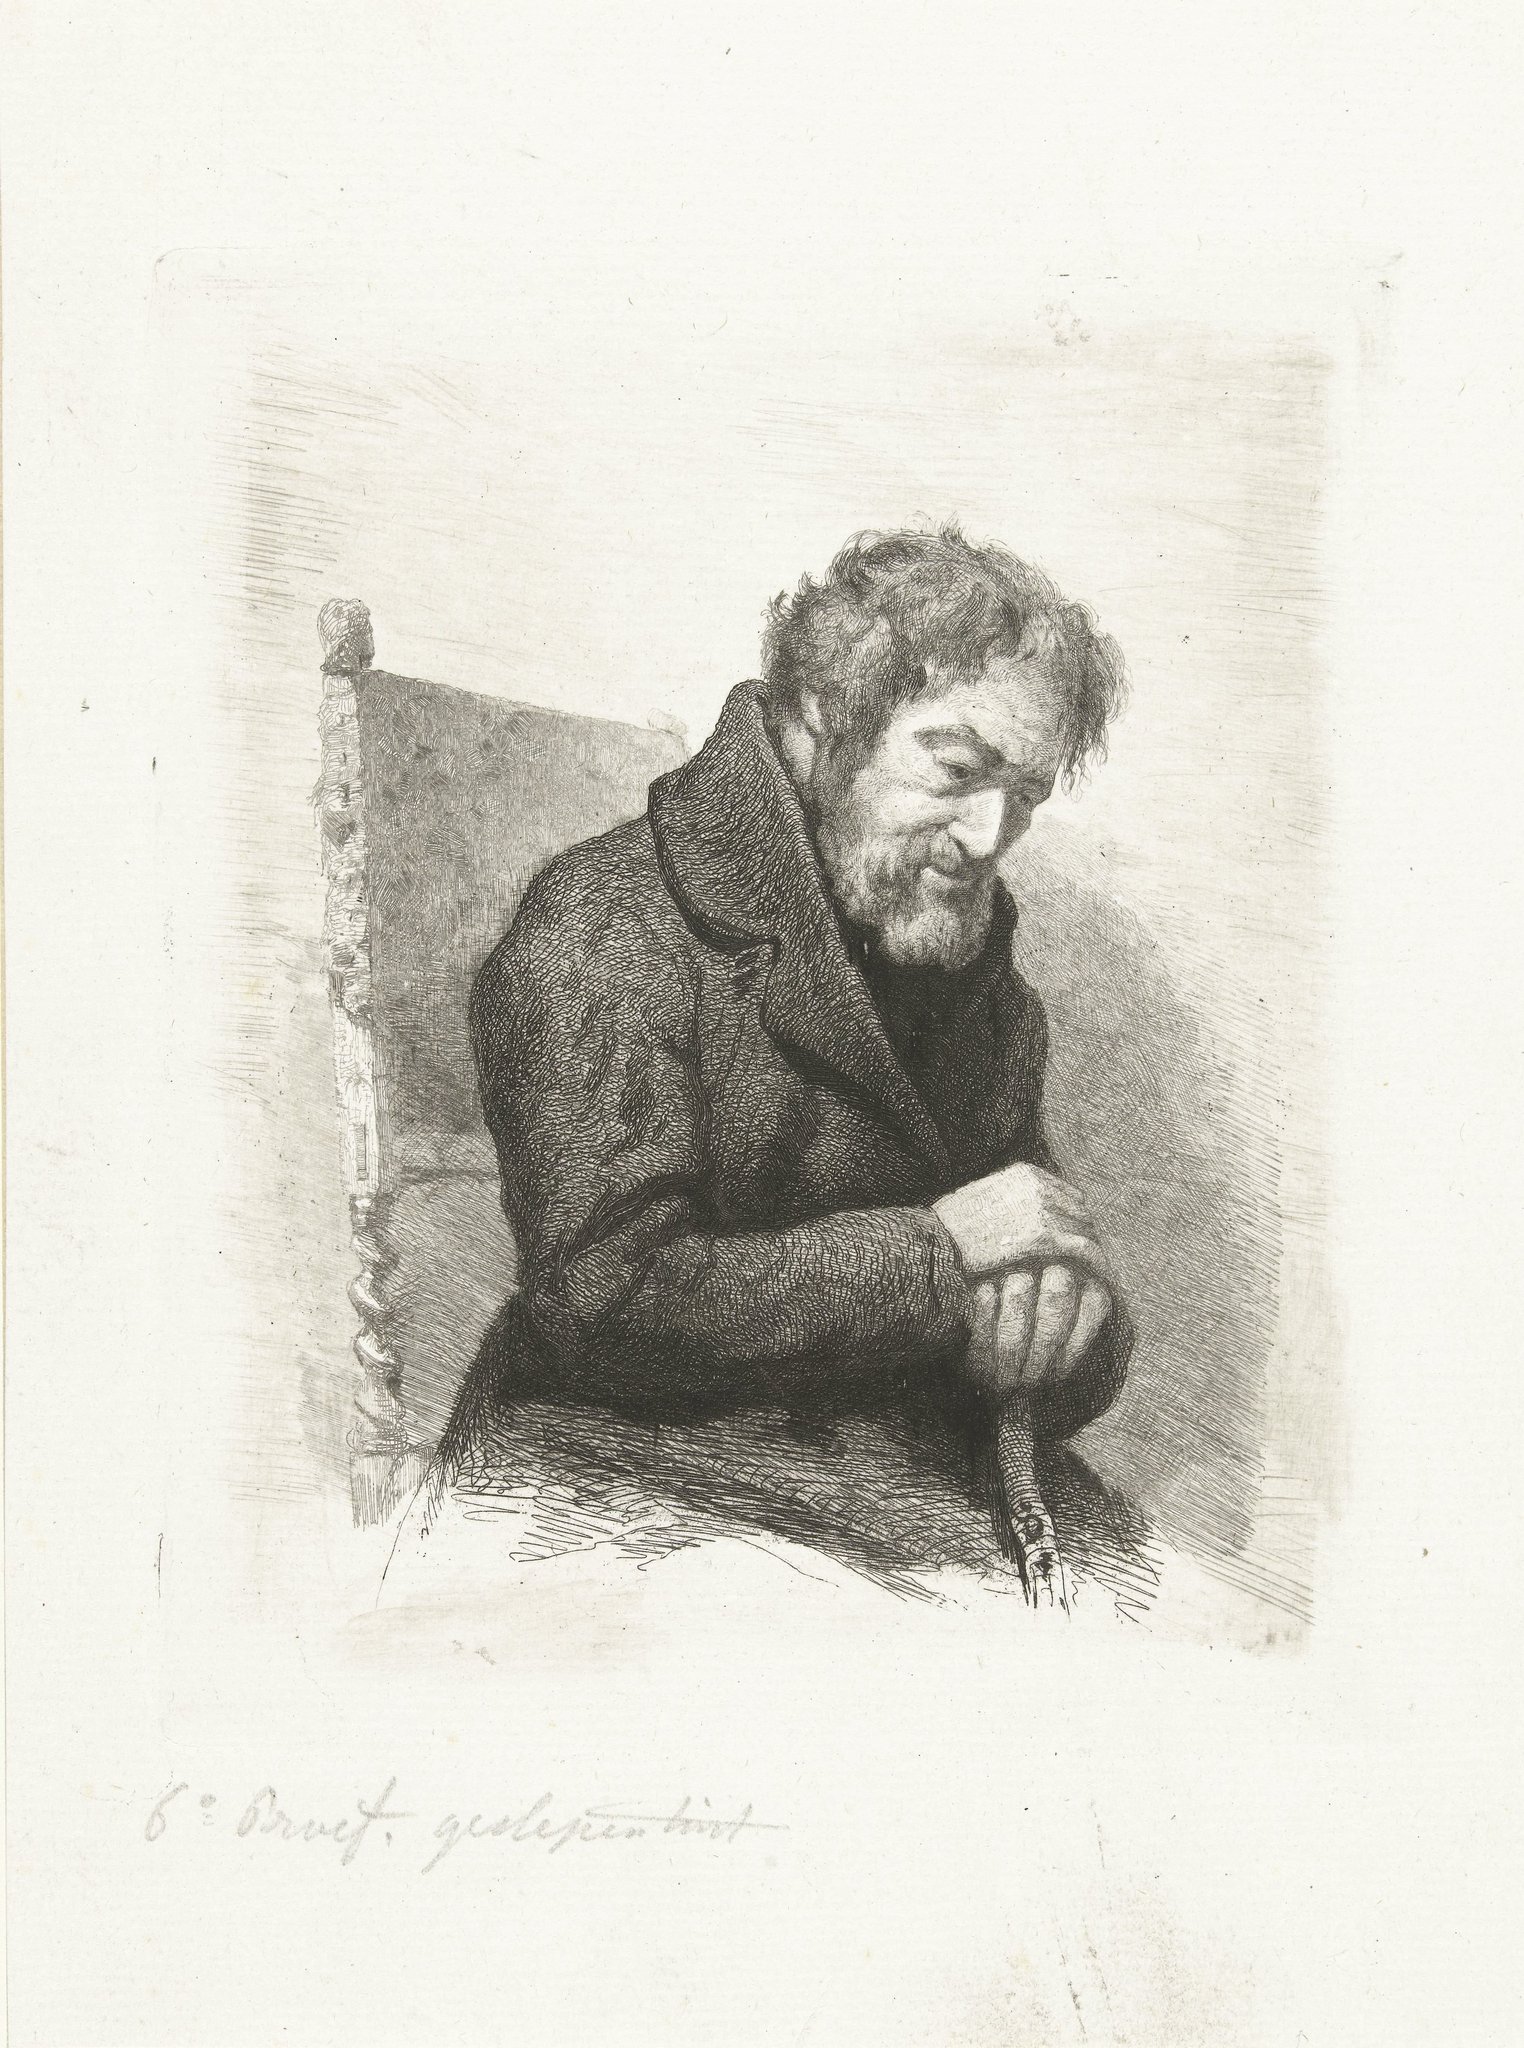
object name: print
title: Zittende grijsaard met wandelstok in zijn handen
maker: pierre louis dubourcq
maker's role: draughtsman, painter, print maker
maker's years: 1815-1873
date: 1845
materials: paper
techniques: etching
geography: netherlands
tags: old man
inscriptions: collector's mark: Lugt 2228